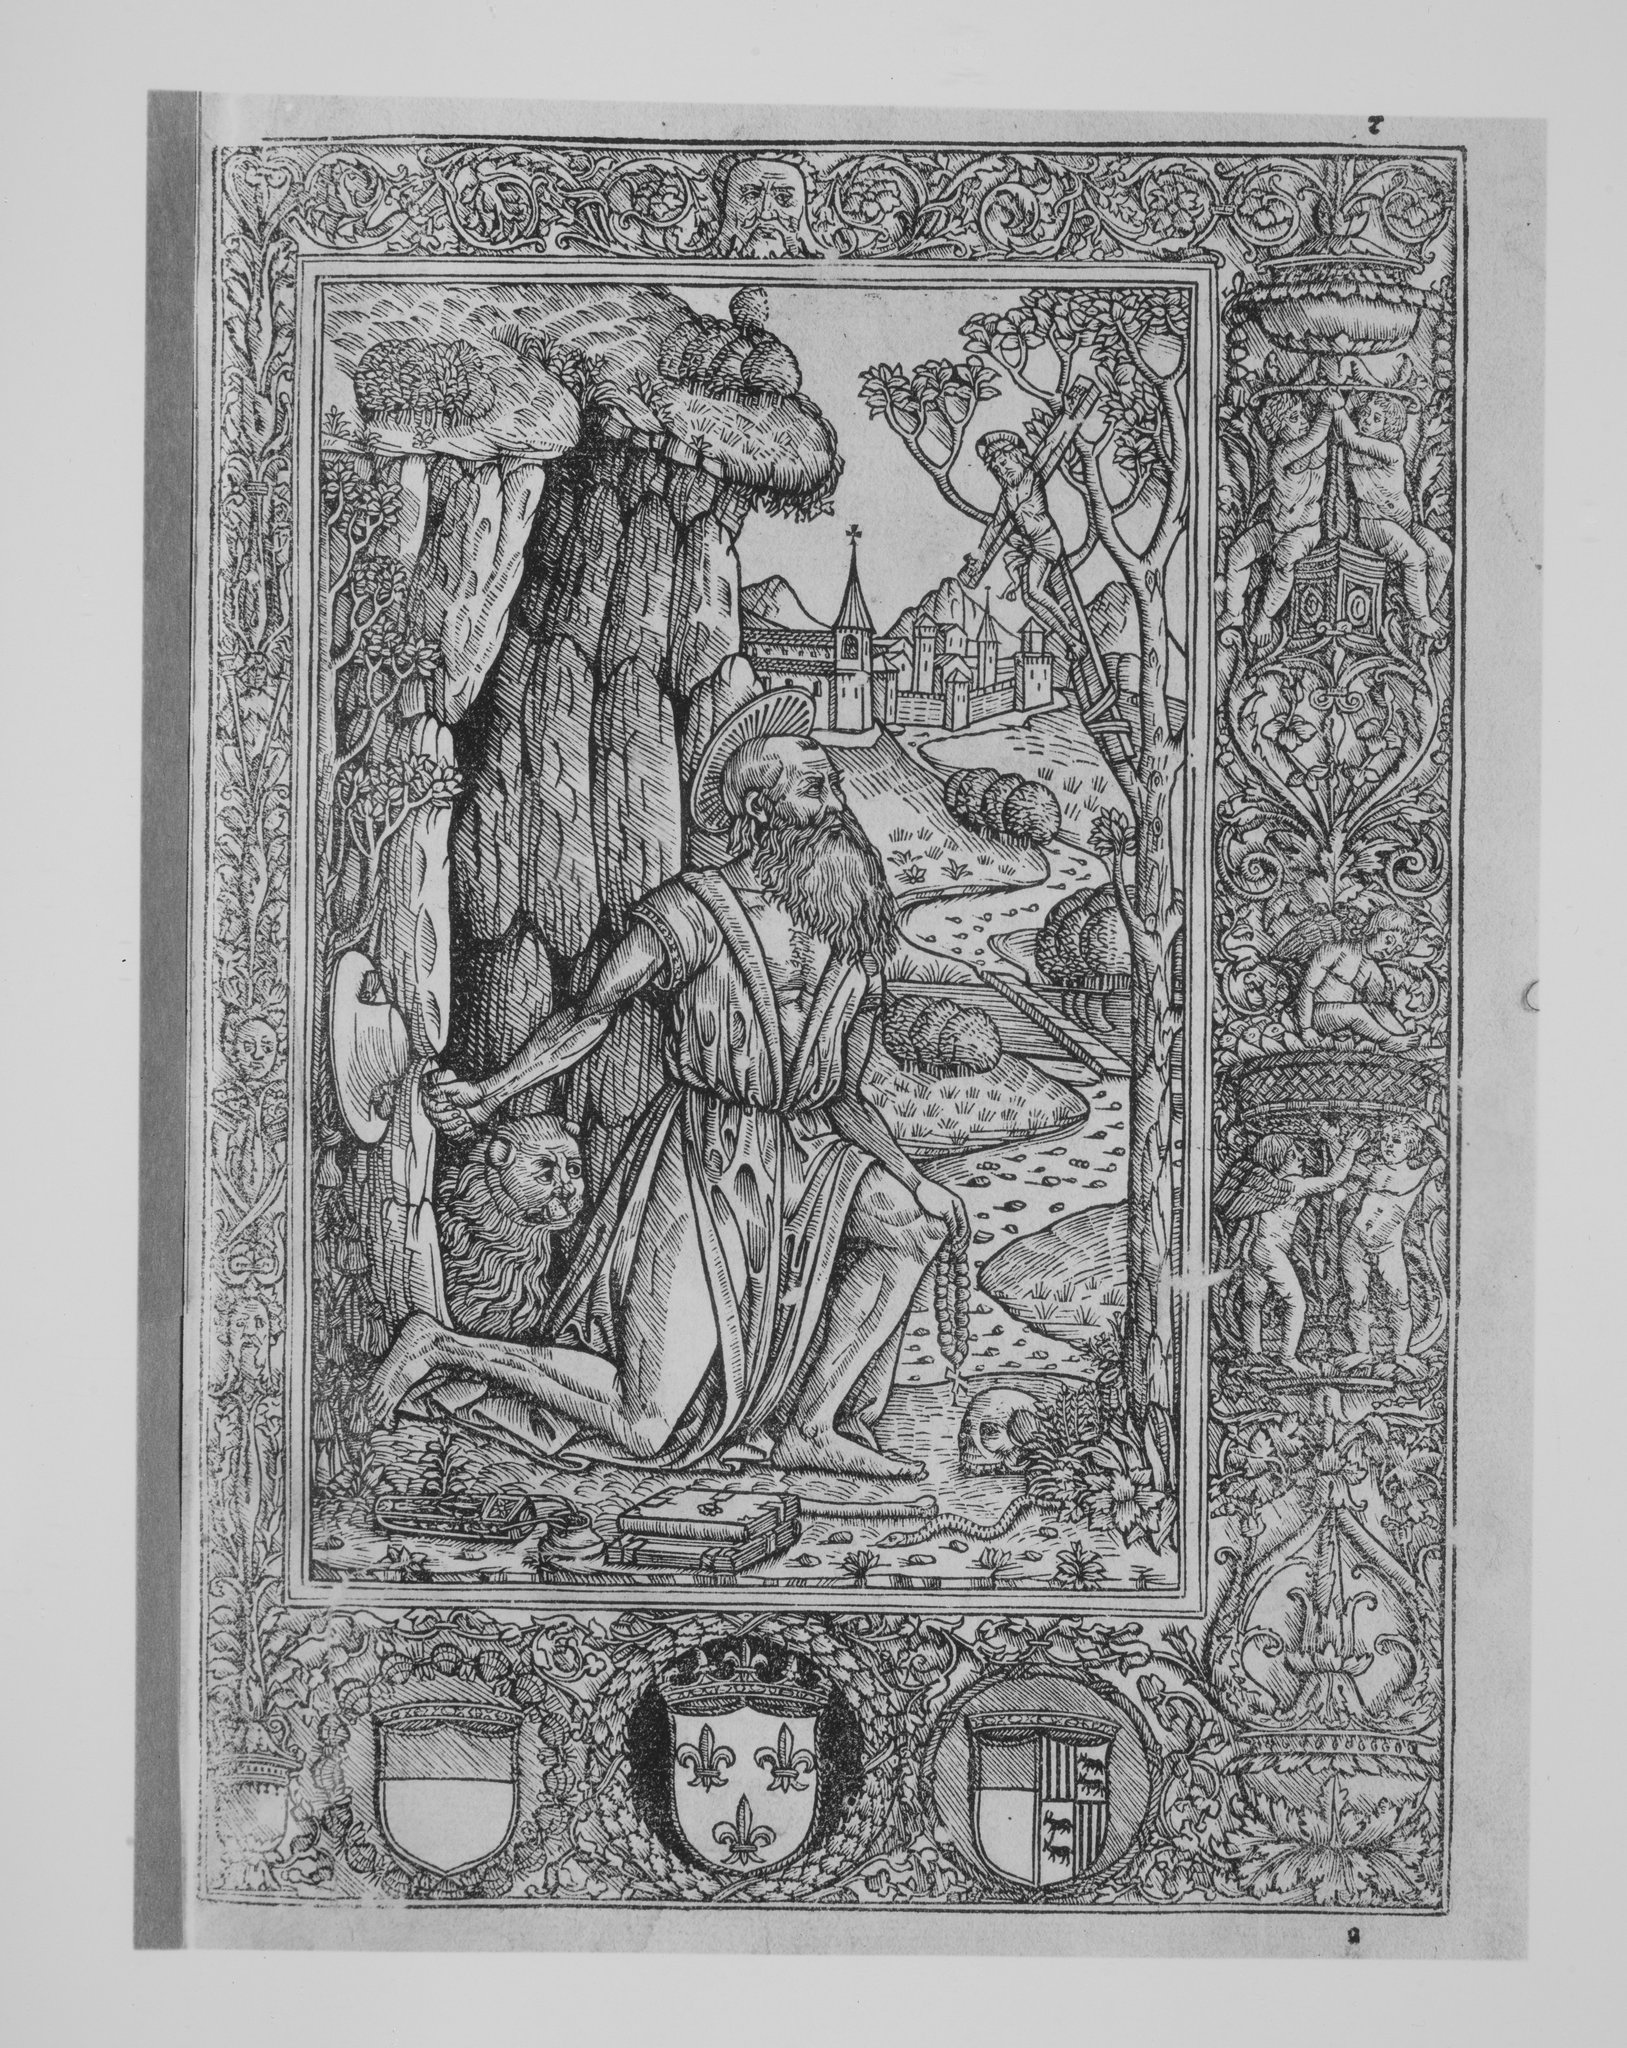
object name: book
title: Aureum opus de veritate contritionis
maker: johannes ludovicus vivaldus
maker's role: author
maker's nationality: italian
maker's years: 1440-1540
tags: men,christ,coat of arms